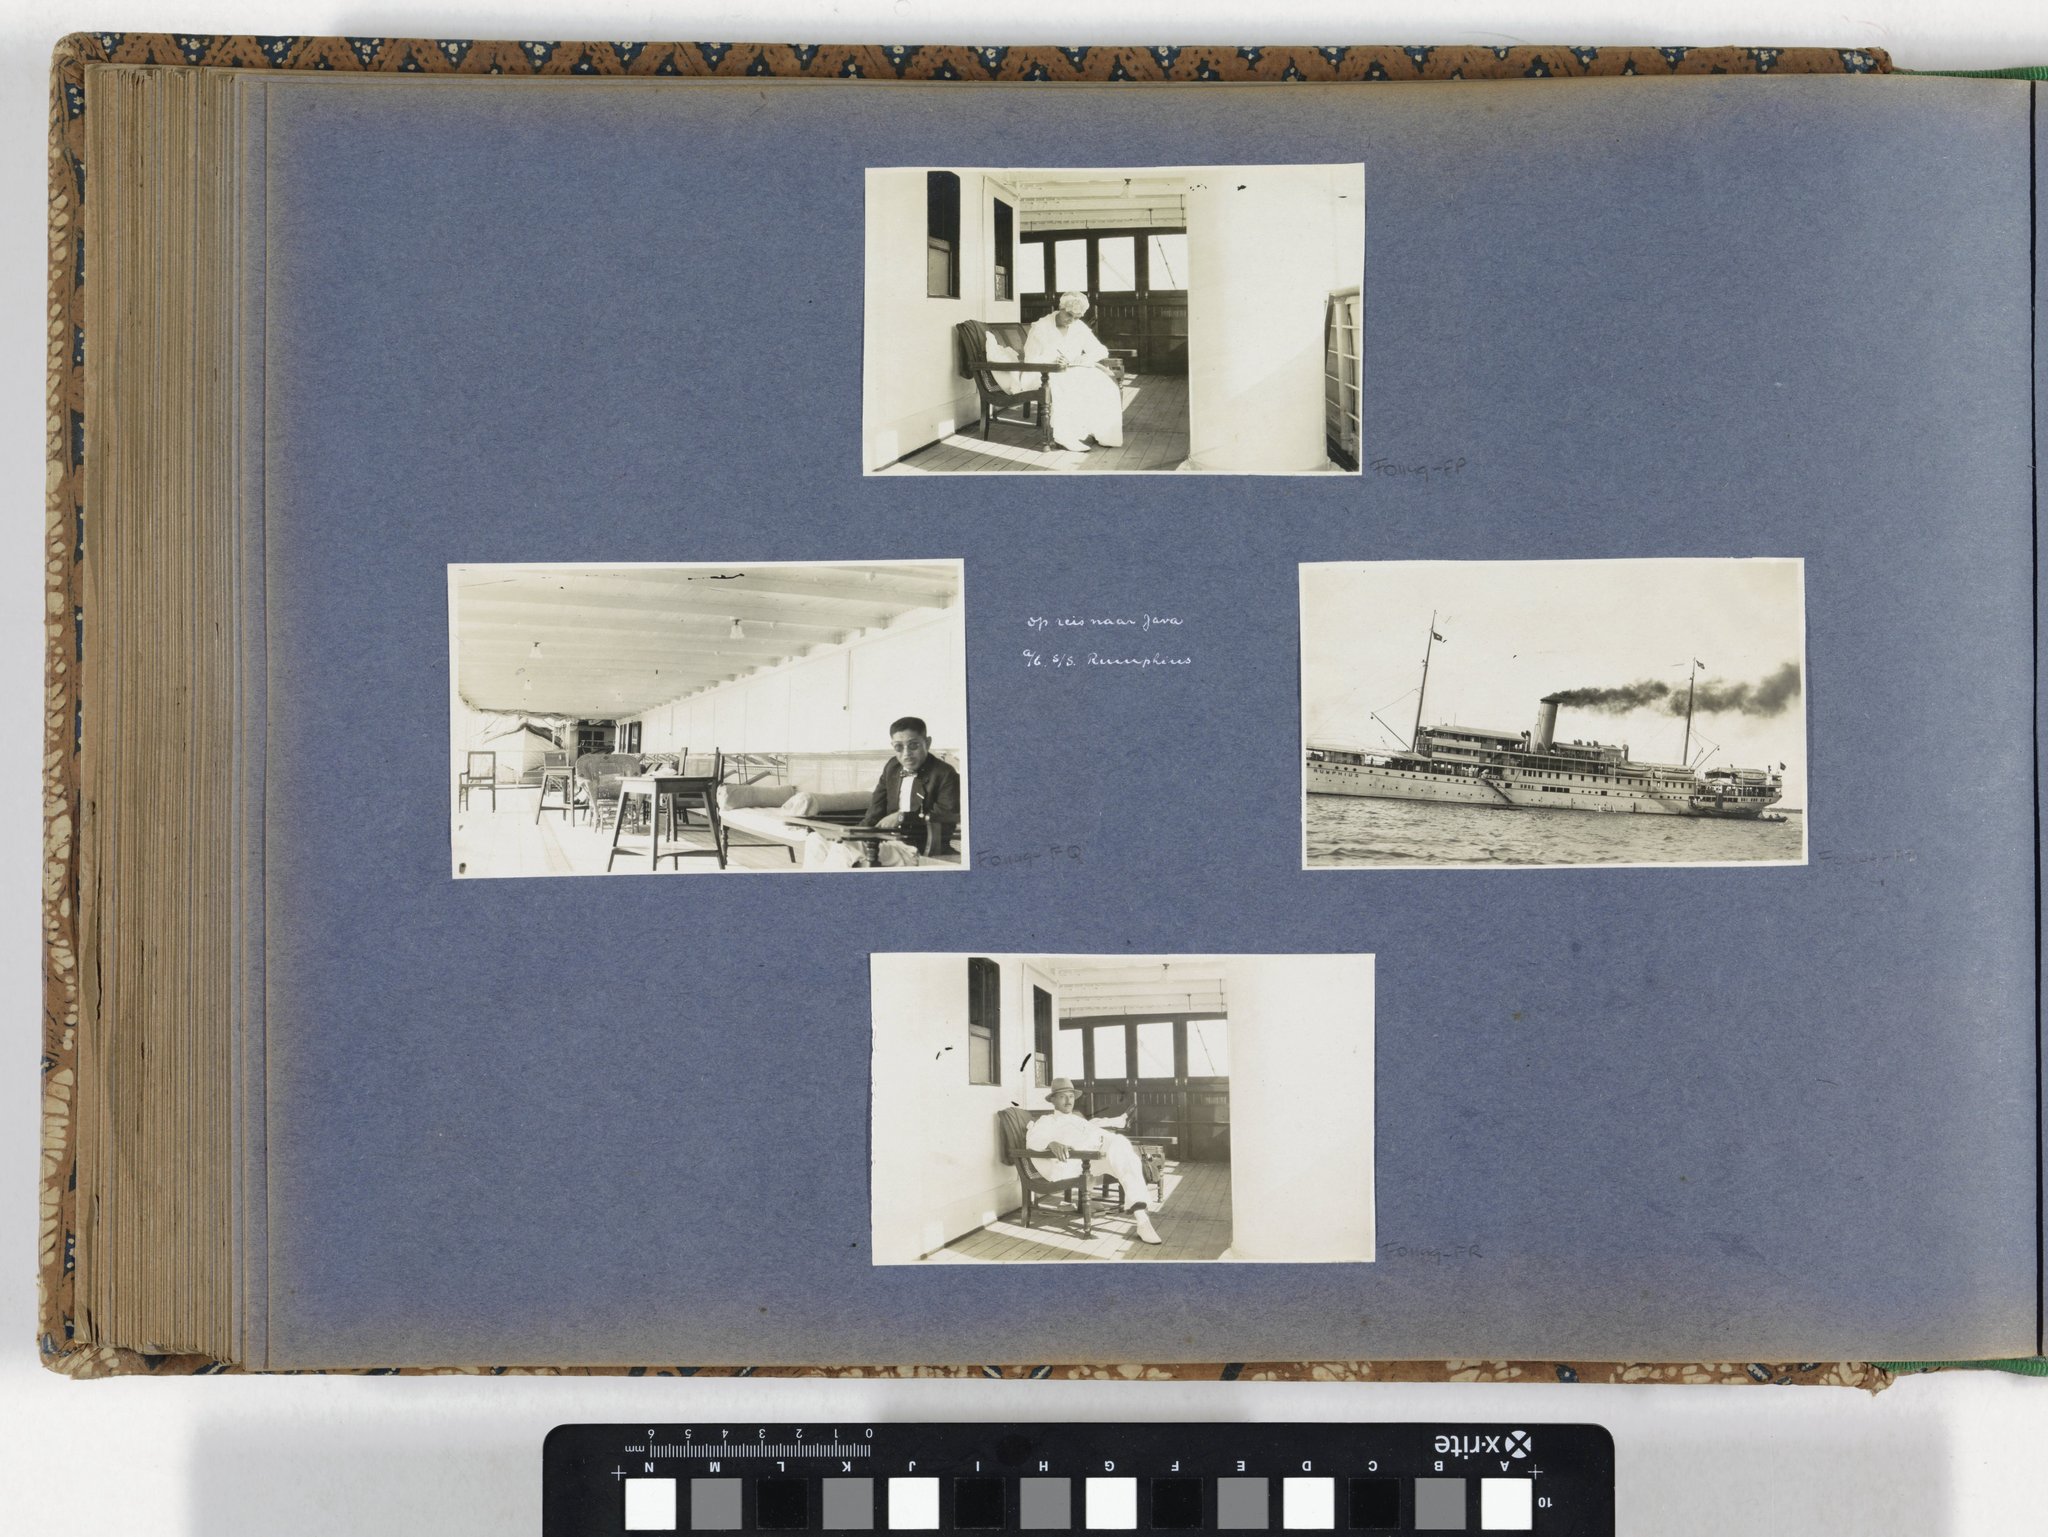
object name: album leaf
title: Schrijvende vrouw aan boord van passagiersschip ss. Rumphius tijdens een reis naar Java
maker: Anonymous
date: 1908-1920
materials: paper, photographic support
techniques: gelatin silver print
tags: handwriting, writing as activity, parts of ship's exterior: deck, passengers ~ ship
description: Onderdeel van reisalbum met foto's van bedrijvigheid en bezienswaardigheden op Sumatra en Java en van de reis naar en van Nederlands-Indië.